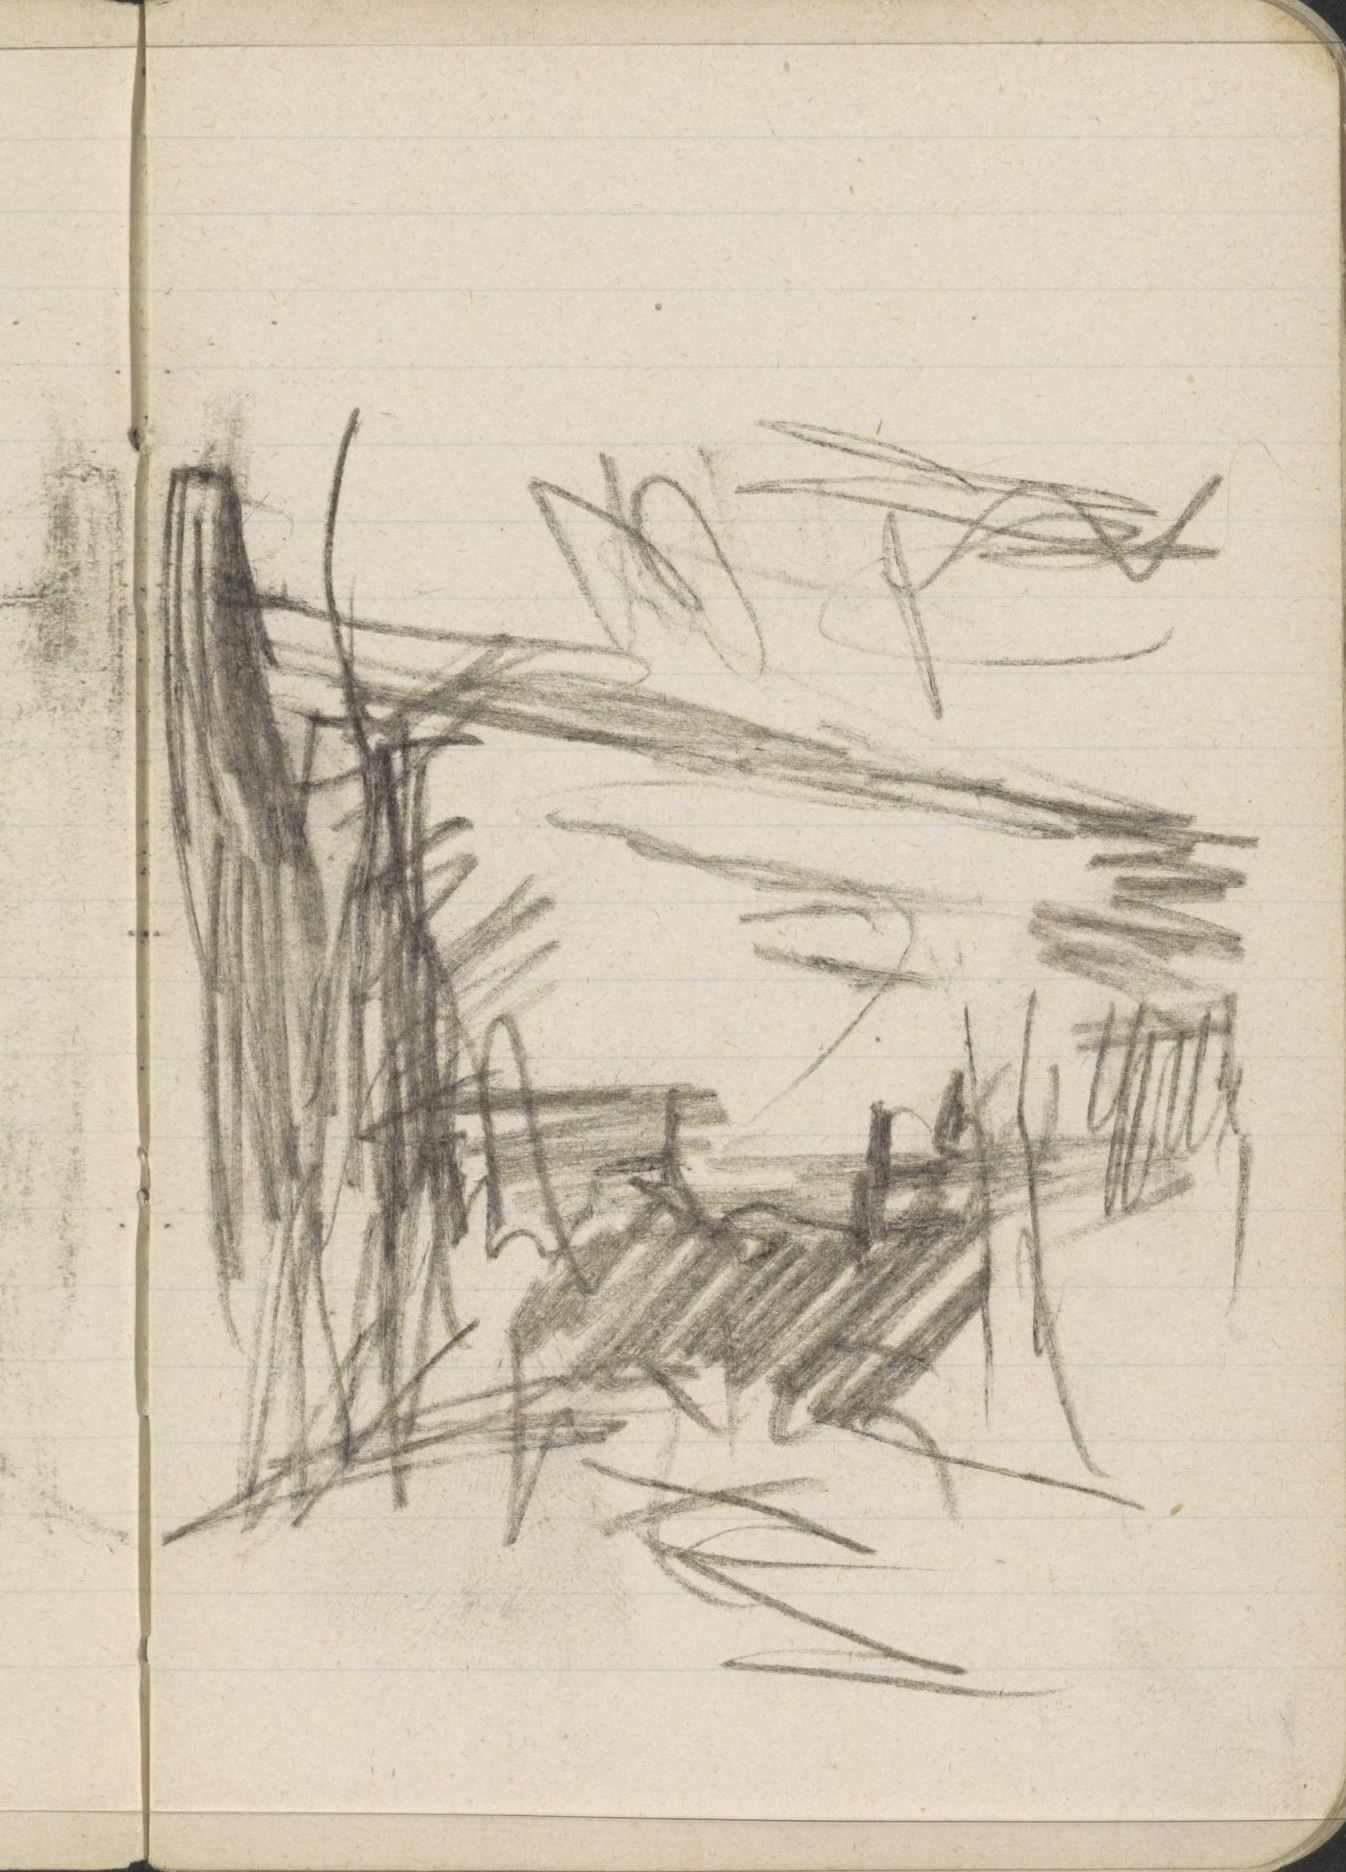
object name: sketchbook leaf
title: Gezicht in Amsterdam, mogelijk de Vossiusstraat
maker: george hendrik breitner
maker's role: draughtsman, painter, print maker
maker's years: 1857-1923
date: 1882-1885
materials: charcoal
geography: amsterdam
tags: street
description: Pagina 3 uit een schetsboek met 34 bladen.